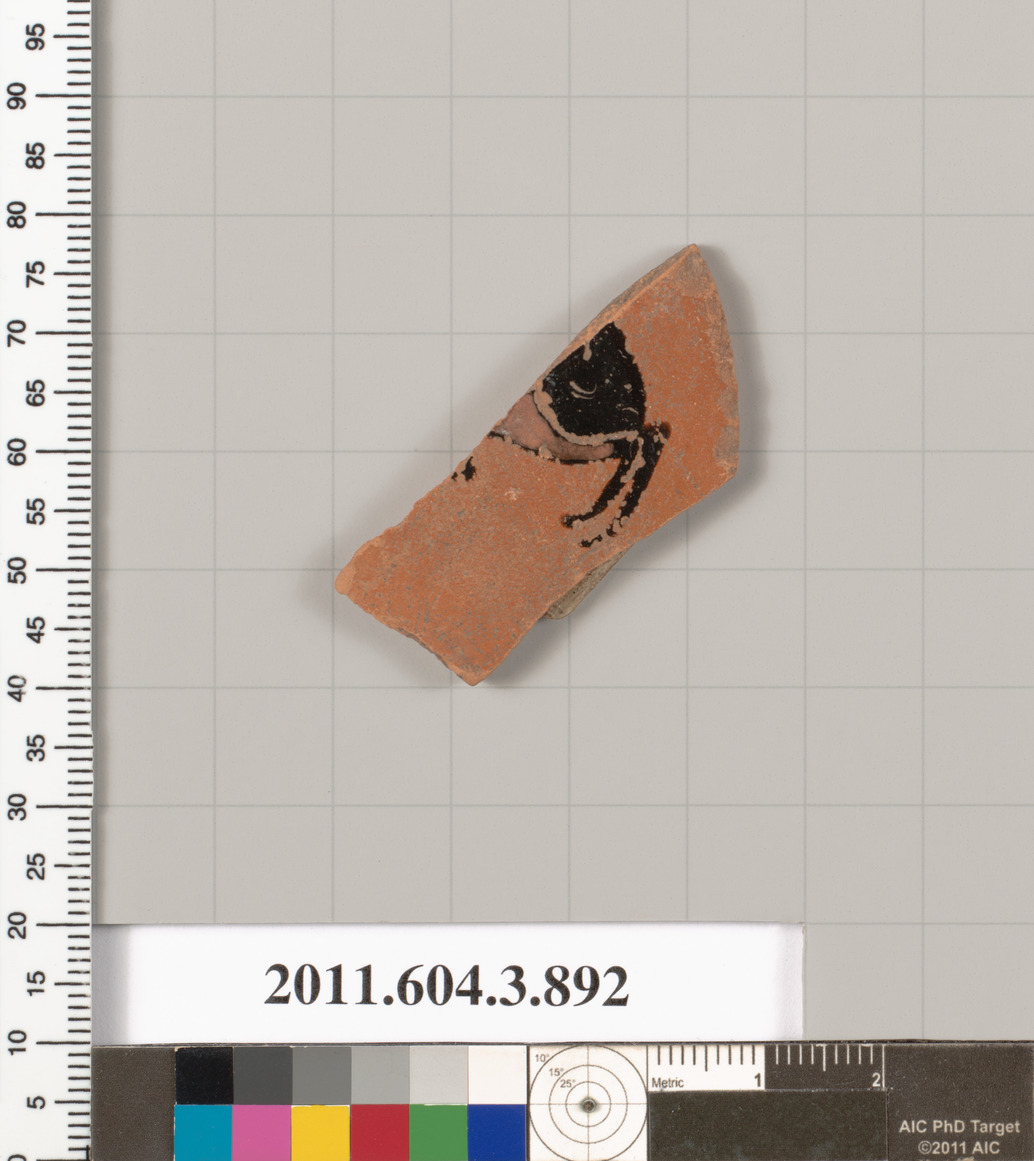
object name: lekythos fragment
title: Terracotta fragment of a lekythos (oil flask)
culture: greek, attic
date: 567-535 BCE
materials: terracotta